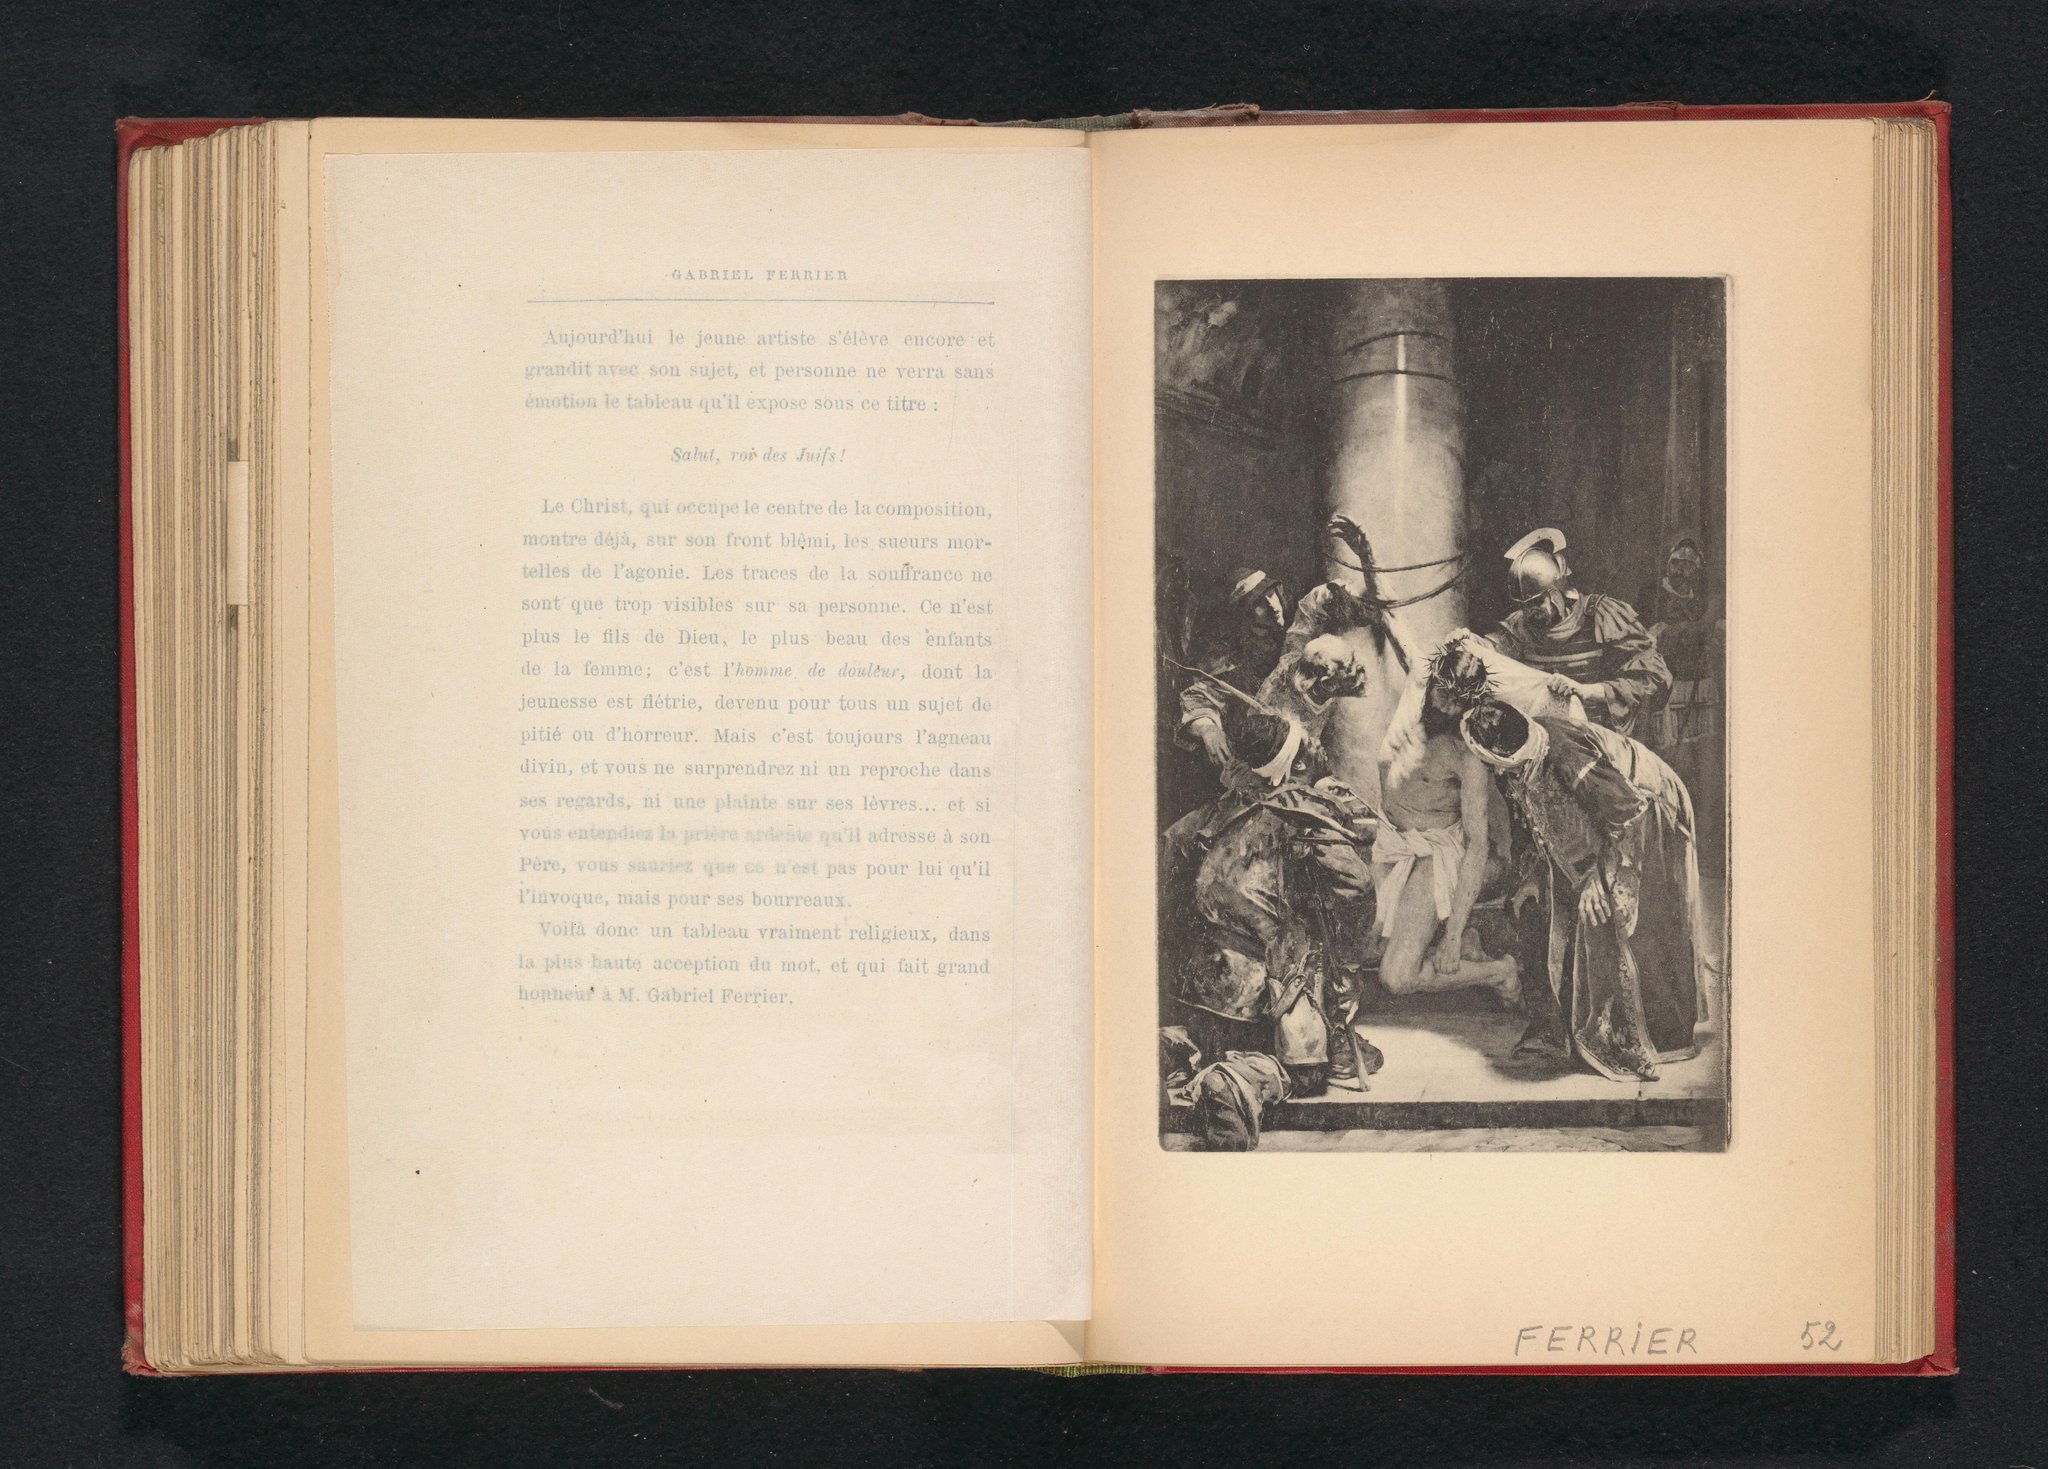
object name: page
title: Fotoreproductie van een schilderij, voorstellende de geseling van Christus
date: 1872-1882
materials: paper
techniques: photograph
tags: flagellation by soldiers, christ usually tied to a column (matthew 27:26; mark 15:15; john 19:1)